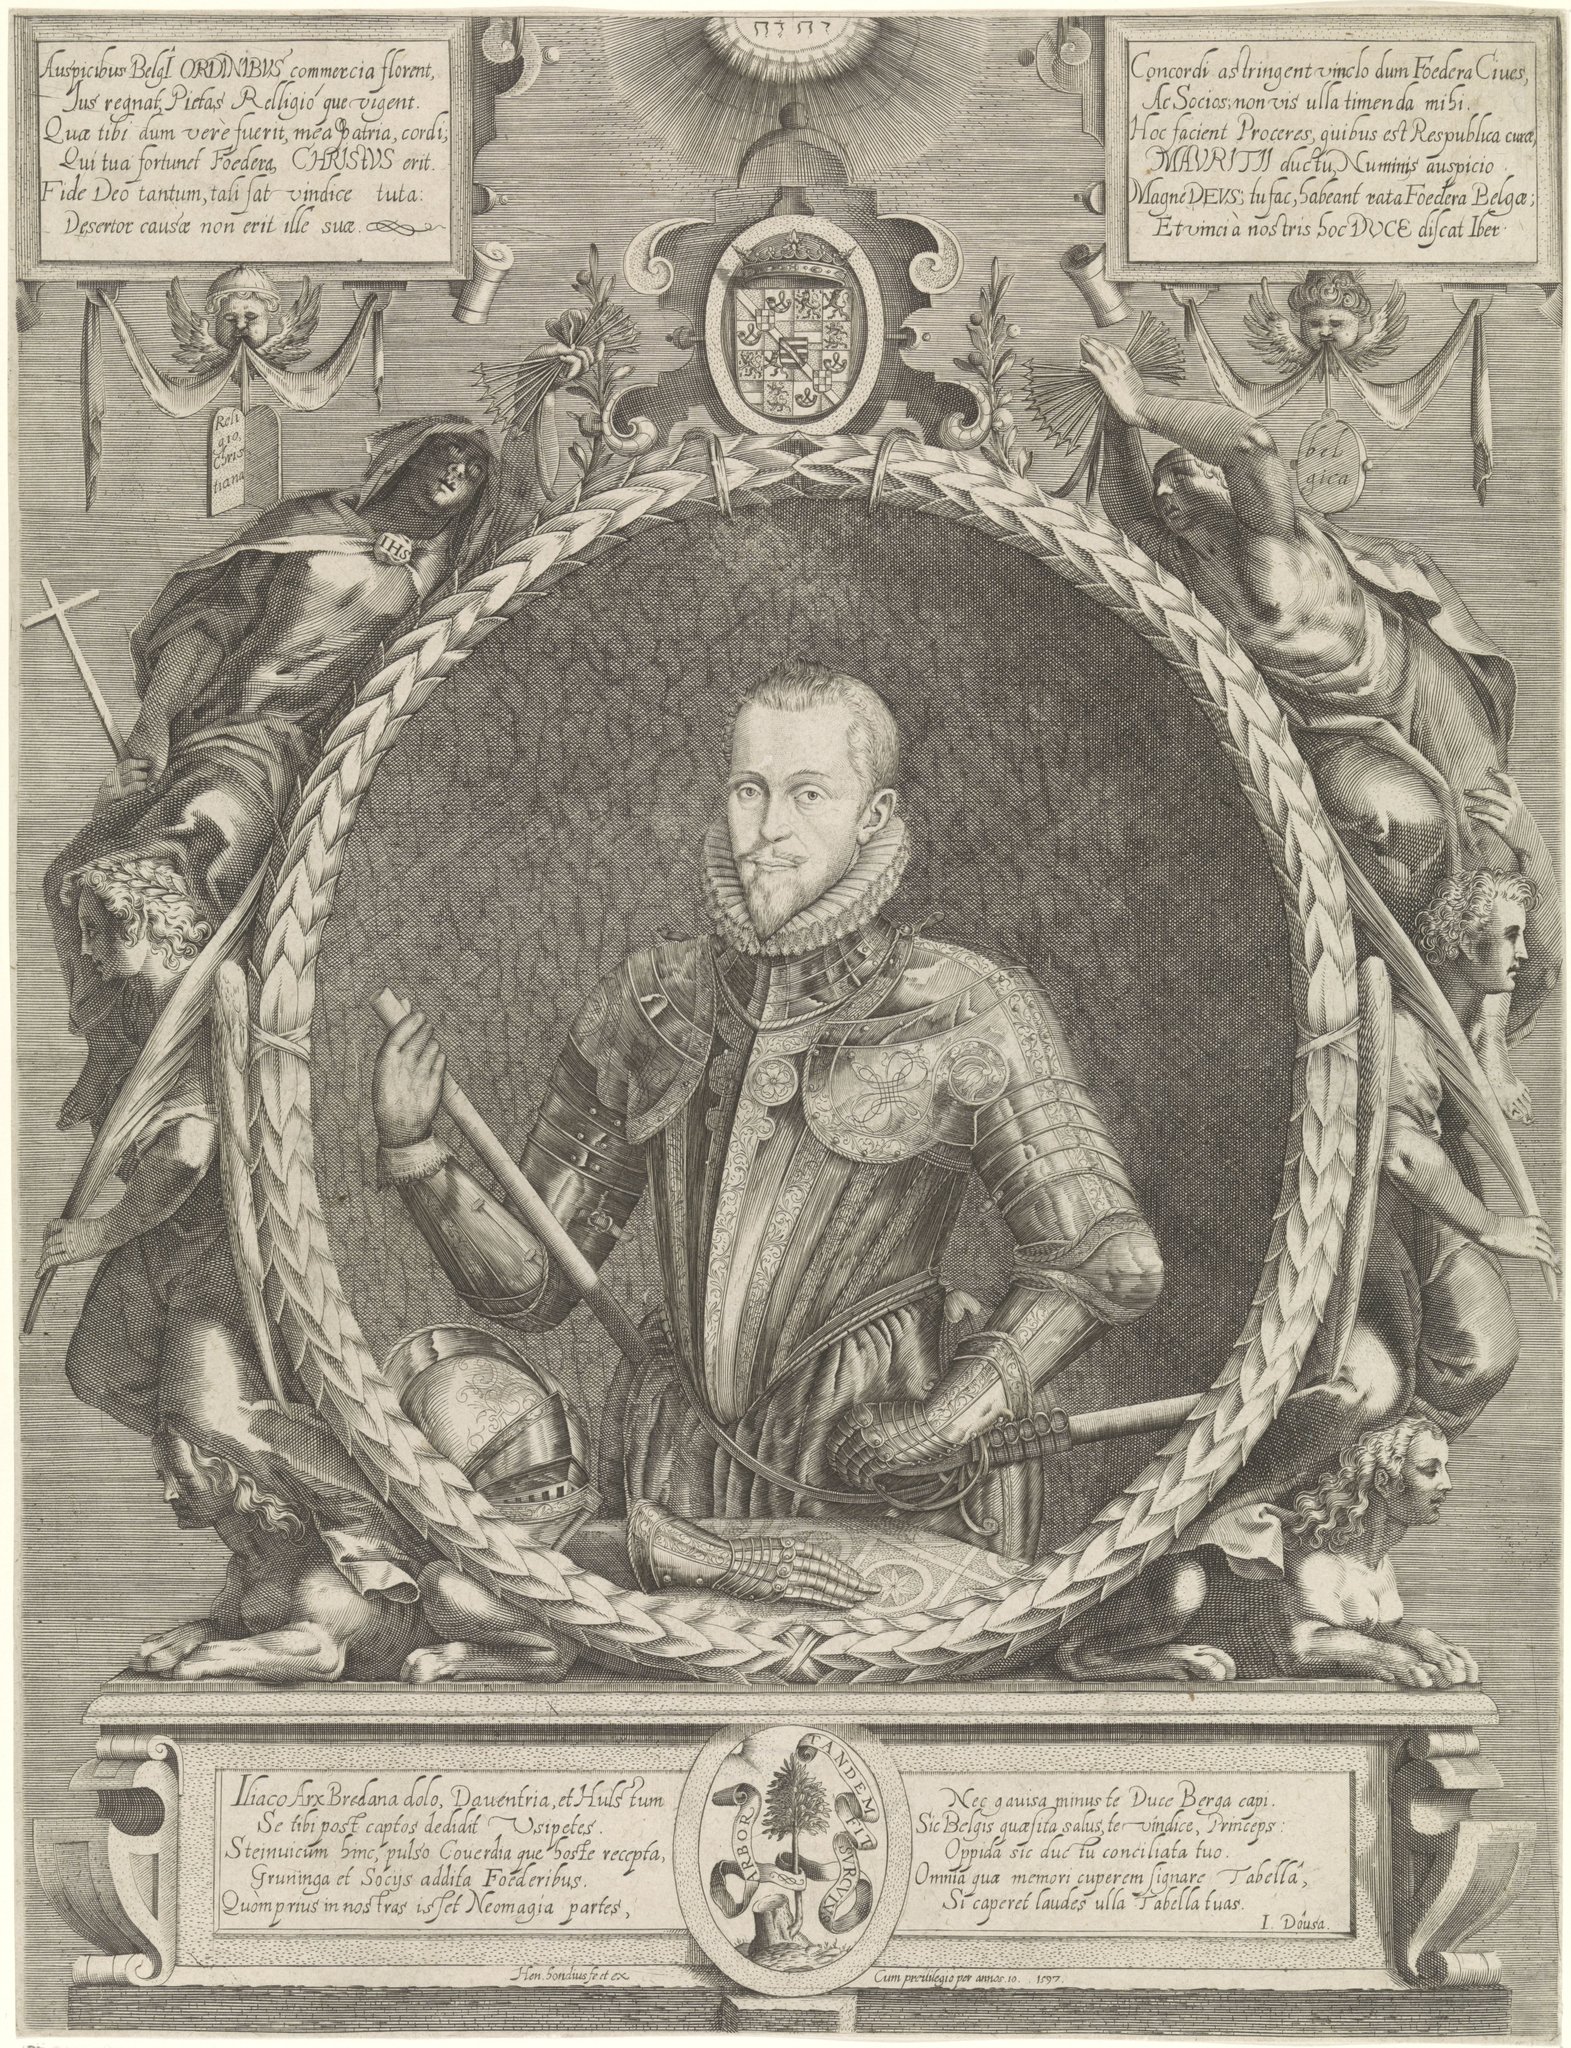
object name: print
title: Portret van Maurits, prins van Oranje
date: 1597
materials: paper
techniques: engraving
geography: the hague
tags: the hague, maurice (prince of orange)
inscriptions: collector's mark: Lugt 2228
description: Portret ten halven lijve van Maurits, prins van Oranje in een ovale lauwerkrans. In de linker- en rechterbovenhoek twee cartouches waaronder cherubijnen, met daarop een tekst van elk zes regels in het Latijn. Het portret rust op een piëdestal, met tevens tekst van twee kolommen van elk vijf regels in het Latijn en een embleem met een devies in het Latijn op een banderol. Boven het portret een familiewapen en geheel boven een omstraald Tetragram. Aan weerszijden van het portret figuren met palmtakken in de hand en met pijlen. Links-en rechtsonder twee sfinxen.